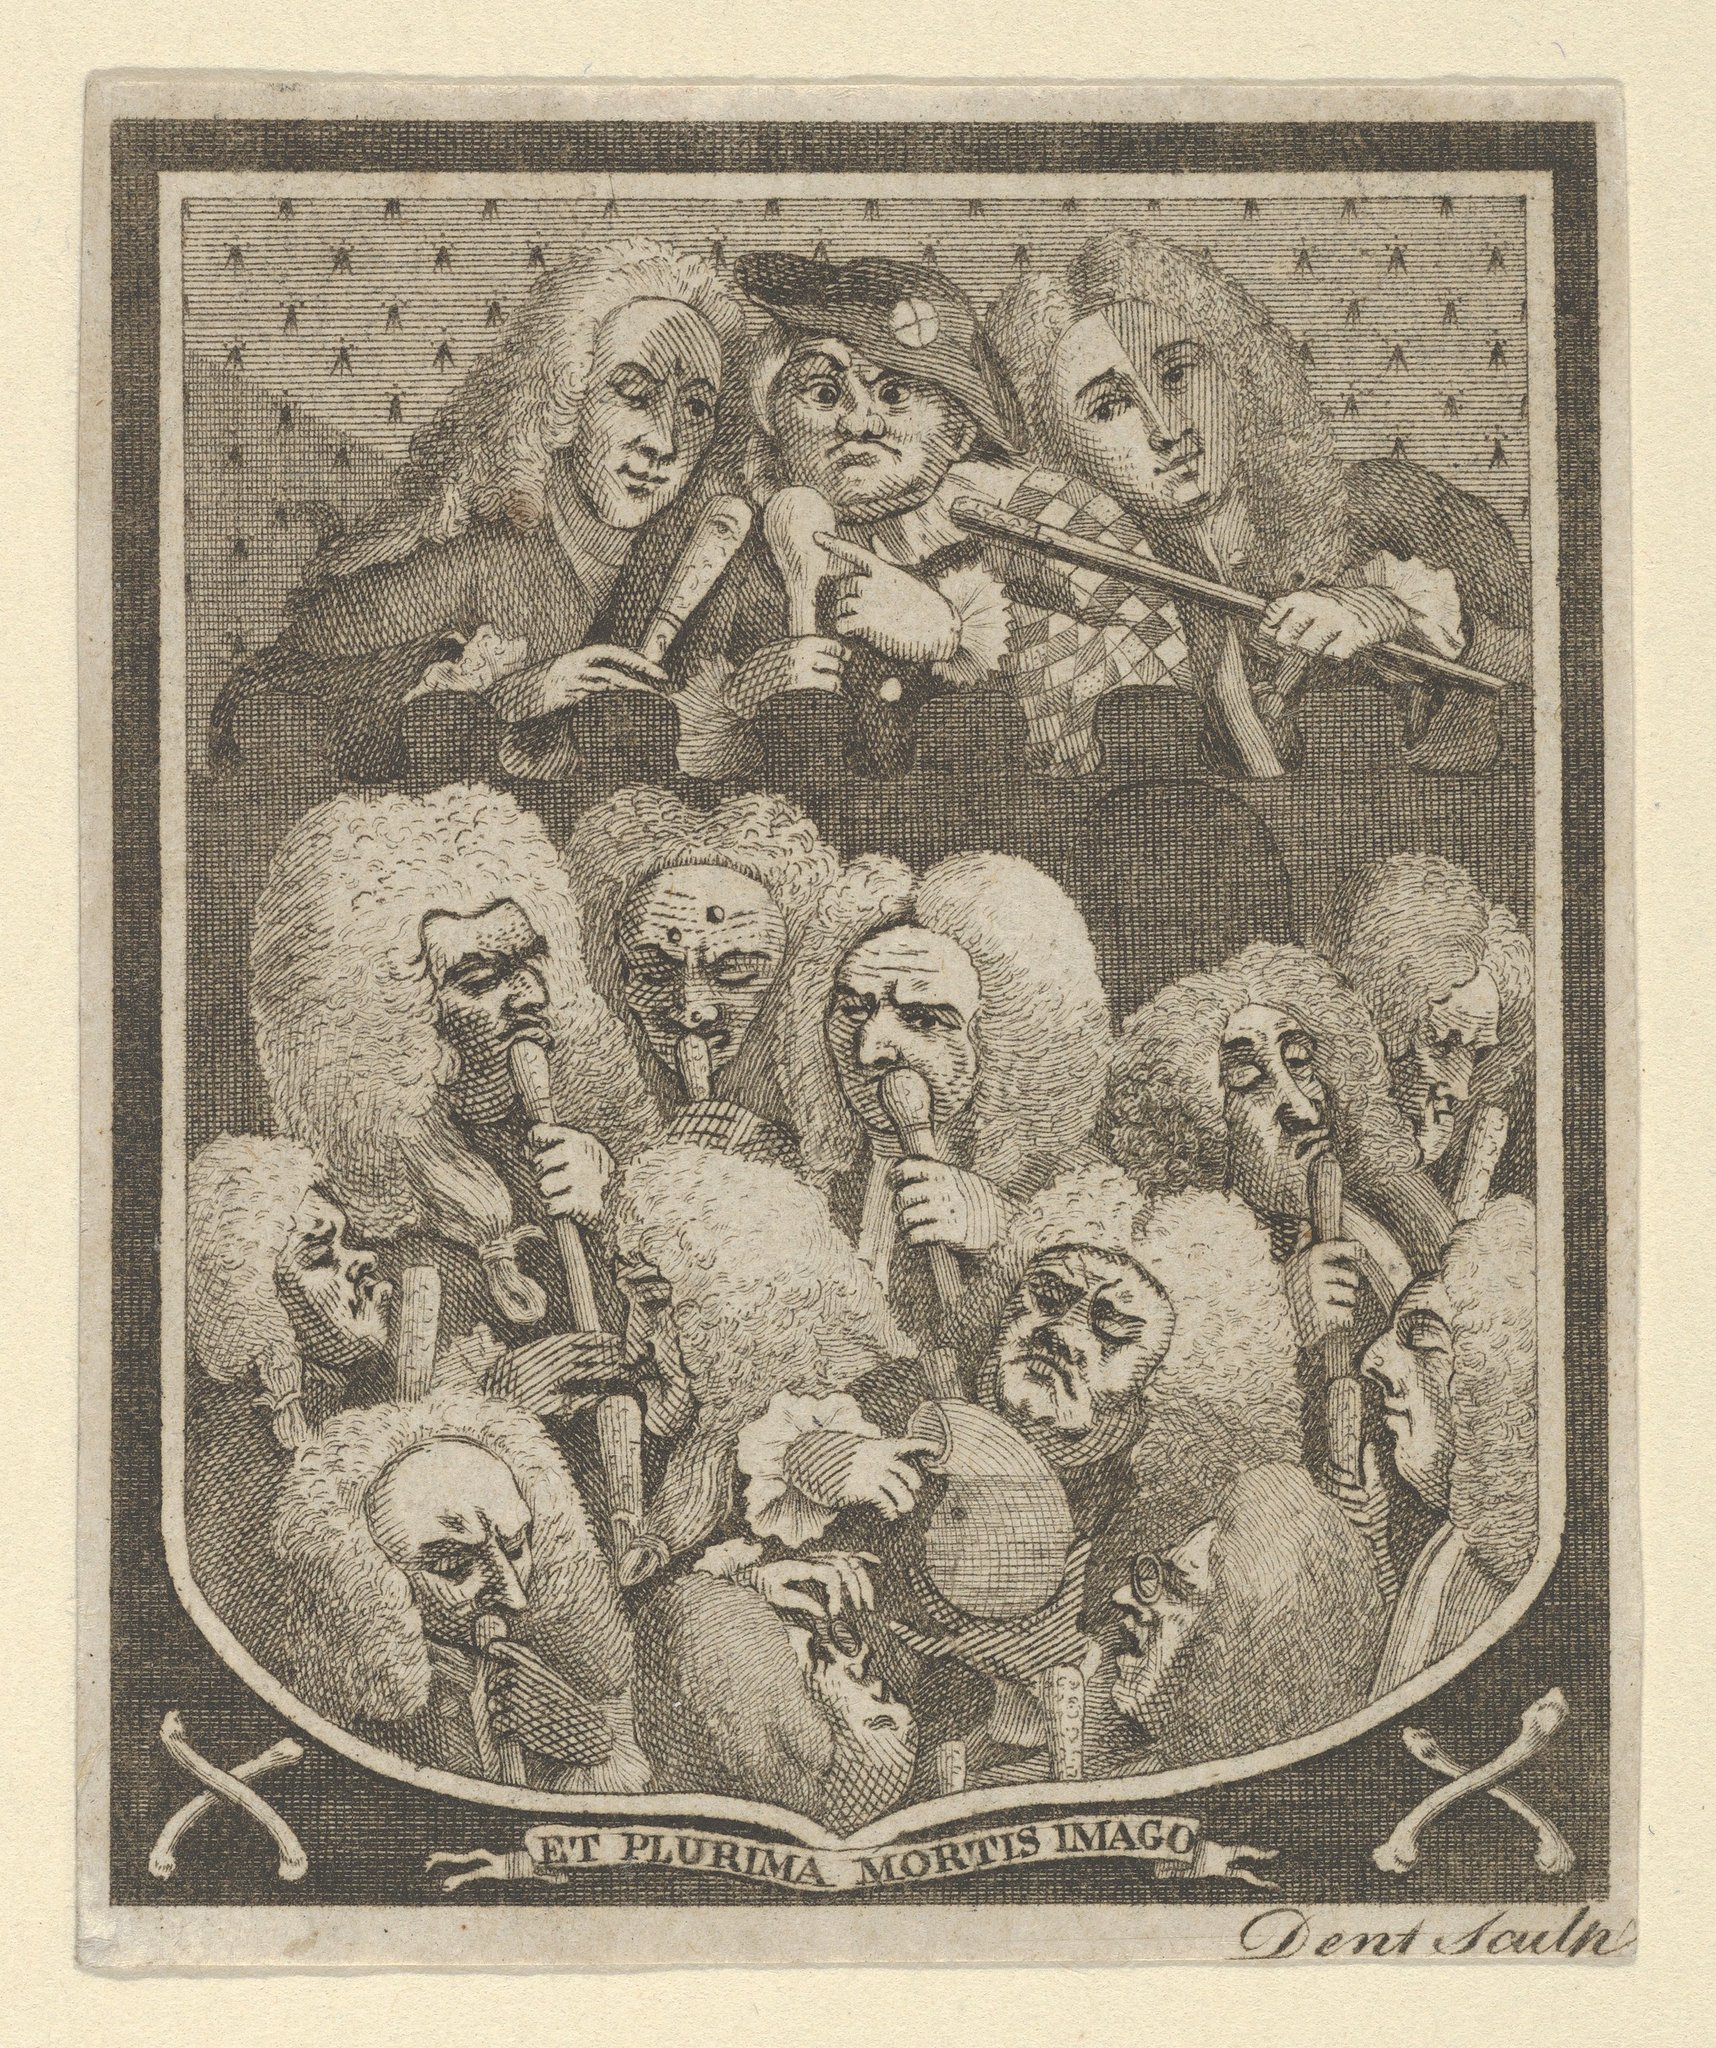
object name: print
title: The Company of Undertakers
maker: dent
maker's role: engraver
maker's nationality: british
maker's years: 1800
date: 1800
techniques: engraving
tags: satire,men